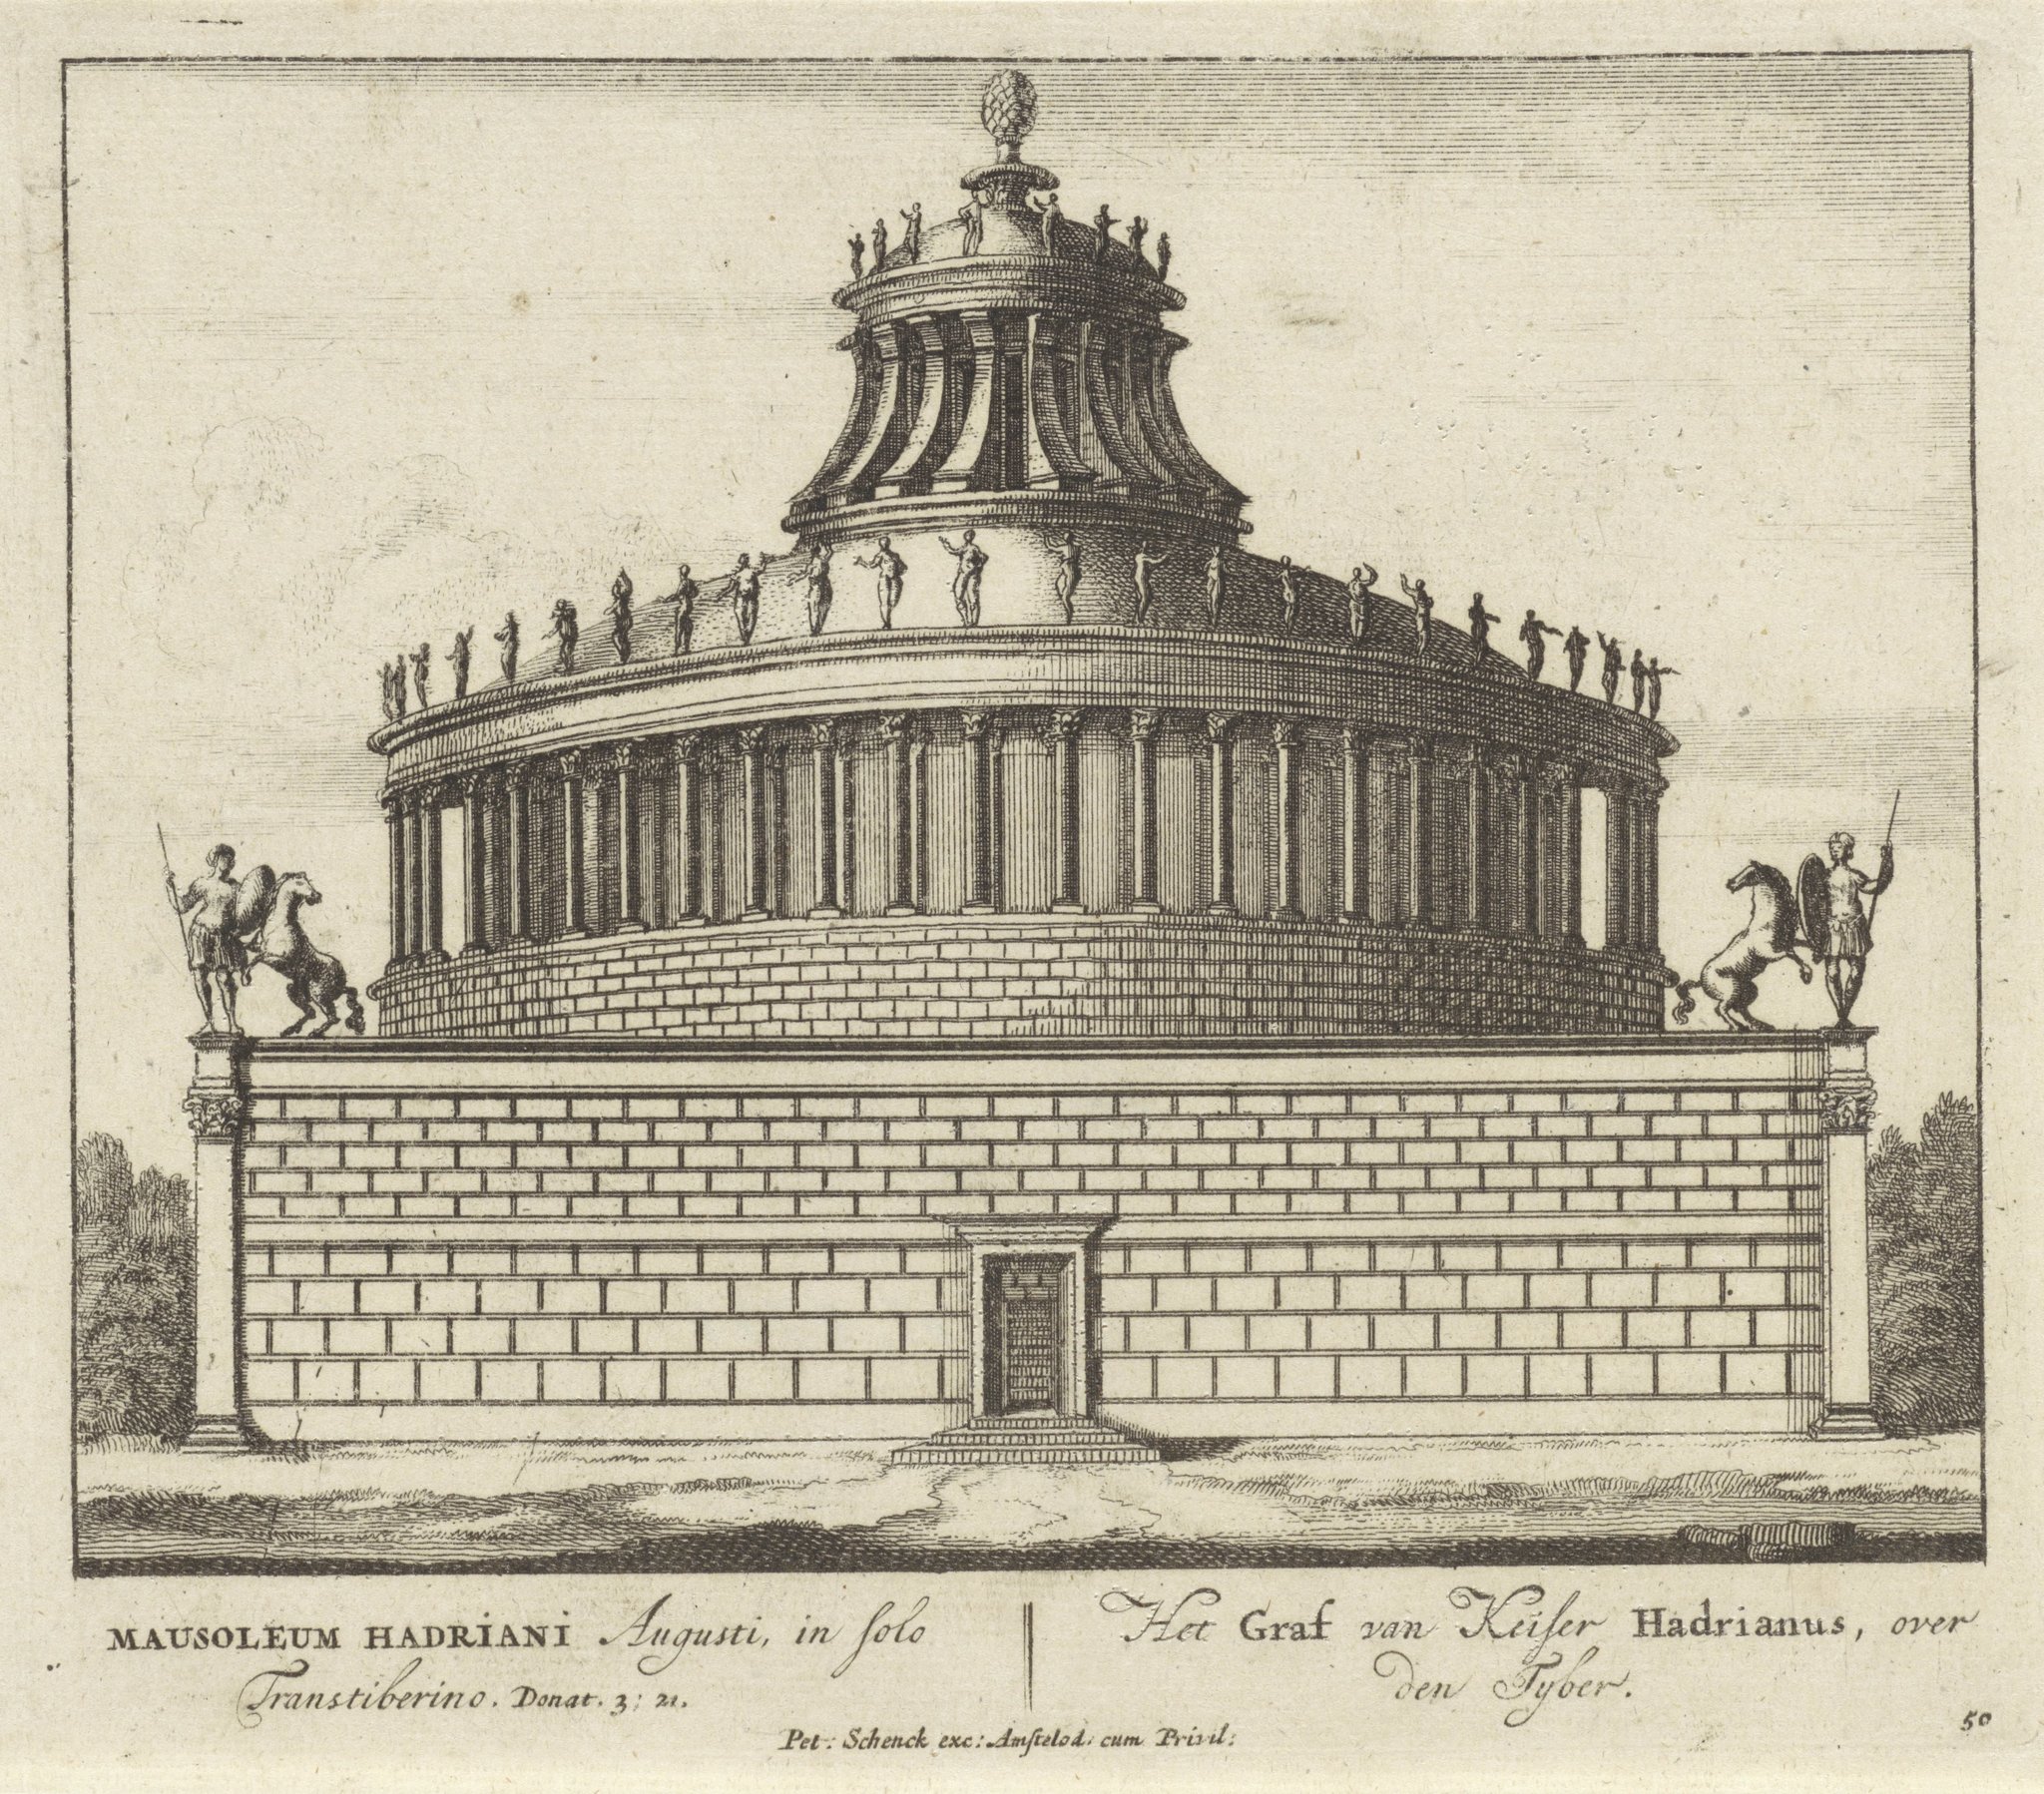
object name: print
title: Het Graf van Keiser Hadrianus, over den Tyber.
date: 1675-1711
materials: paper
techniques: etching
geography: amsterdam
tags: mausoleum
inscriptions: collector's mark: Lugt 2228